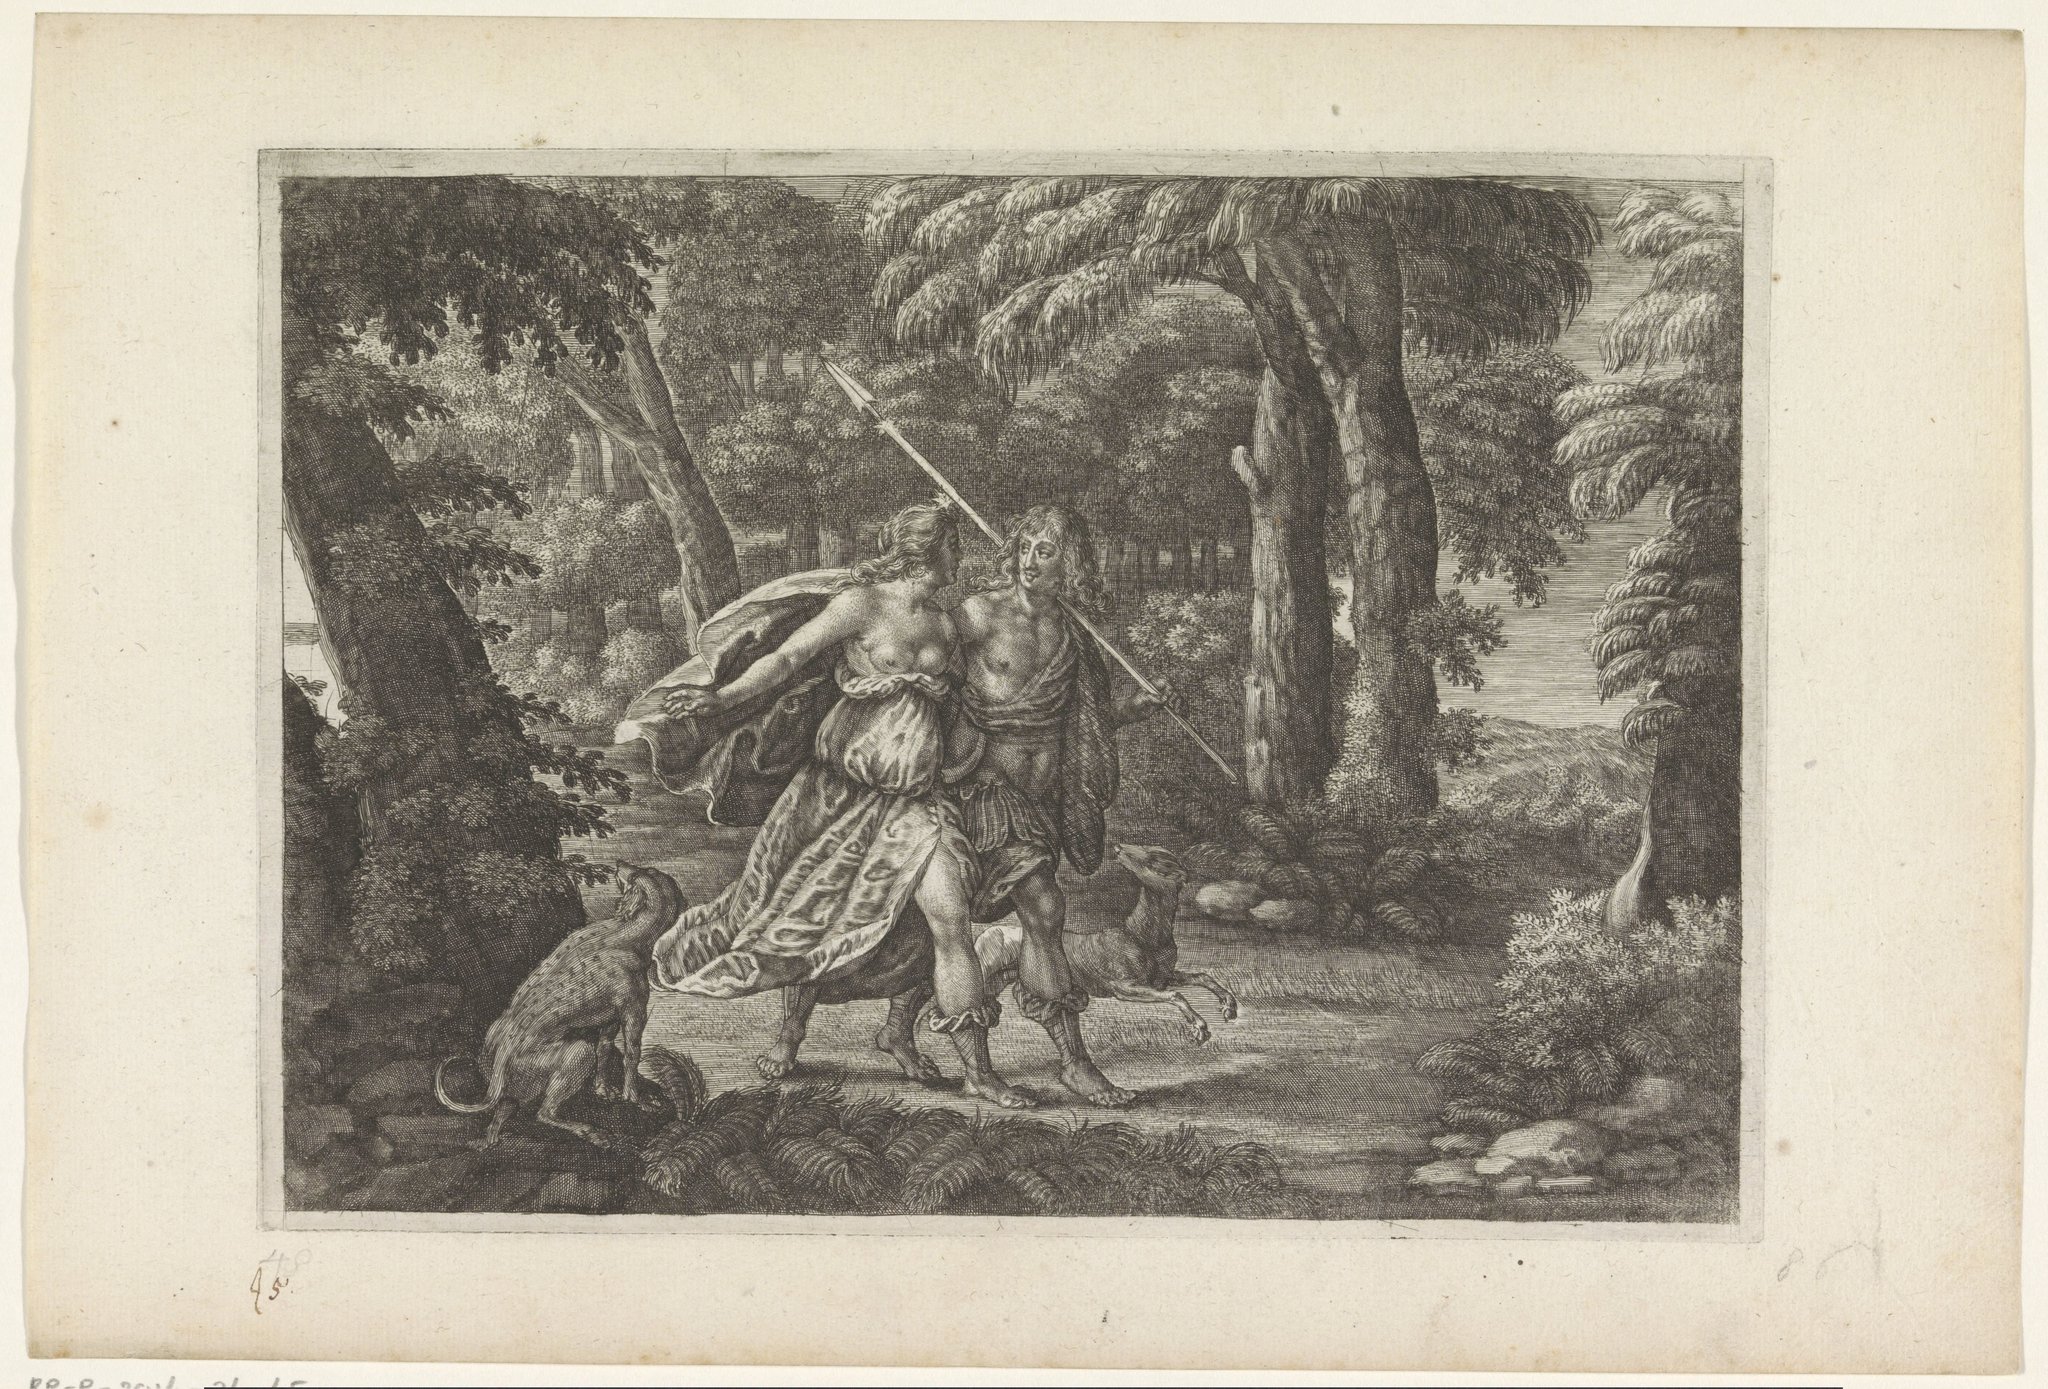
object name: print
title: Metamorfosen van Ovidius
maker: magdalena van de passe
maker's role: print maker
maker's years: 1600-1638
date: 1636-1670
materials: paper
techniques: engraving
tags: cephalus and aurora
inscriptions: collector's mark: ‘Hinloopen’, number: ‘45’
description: Deze incomplete serie, bestaande uit 77 van de in totaal 85 prenten met scènes uit Ovidius' Metamorfosen, werd in 1709 samen met Ovidius-illustraties van Tempesta, Goltzius en Le Pautre in één album, Schijnvoet nummer 43, ingebonden. In de negentiende eeuw werd deze band weer uit elkaar gehaald.